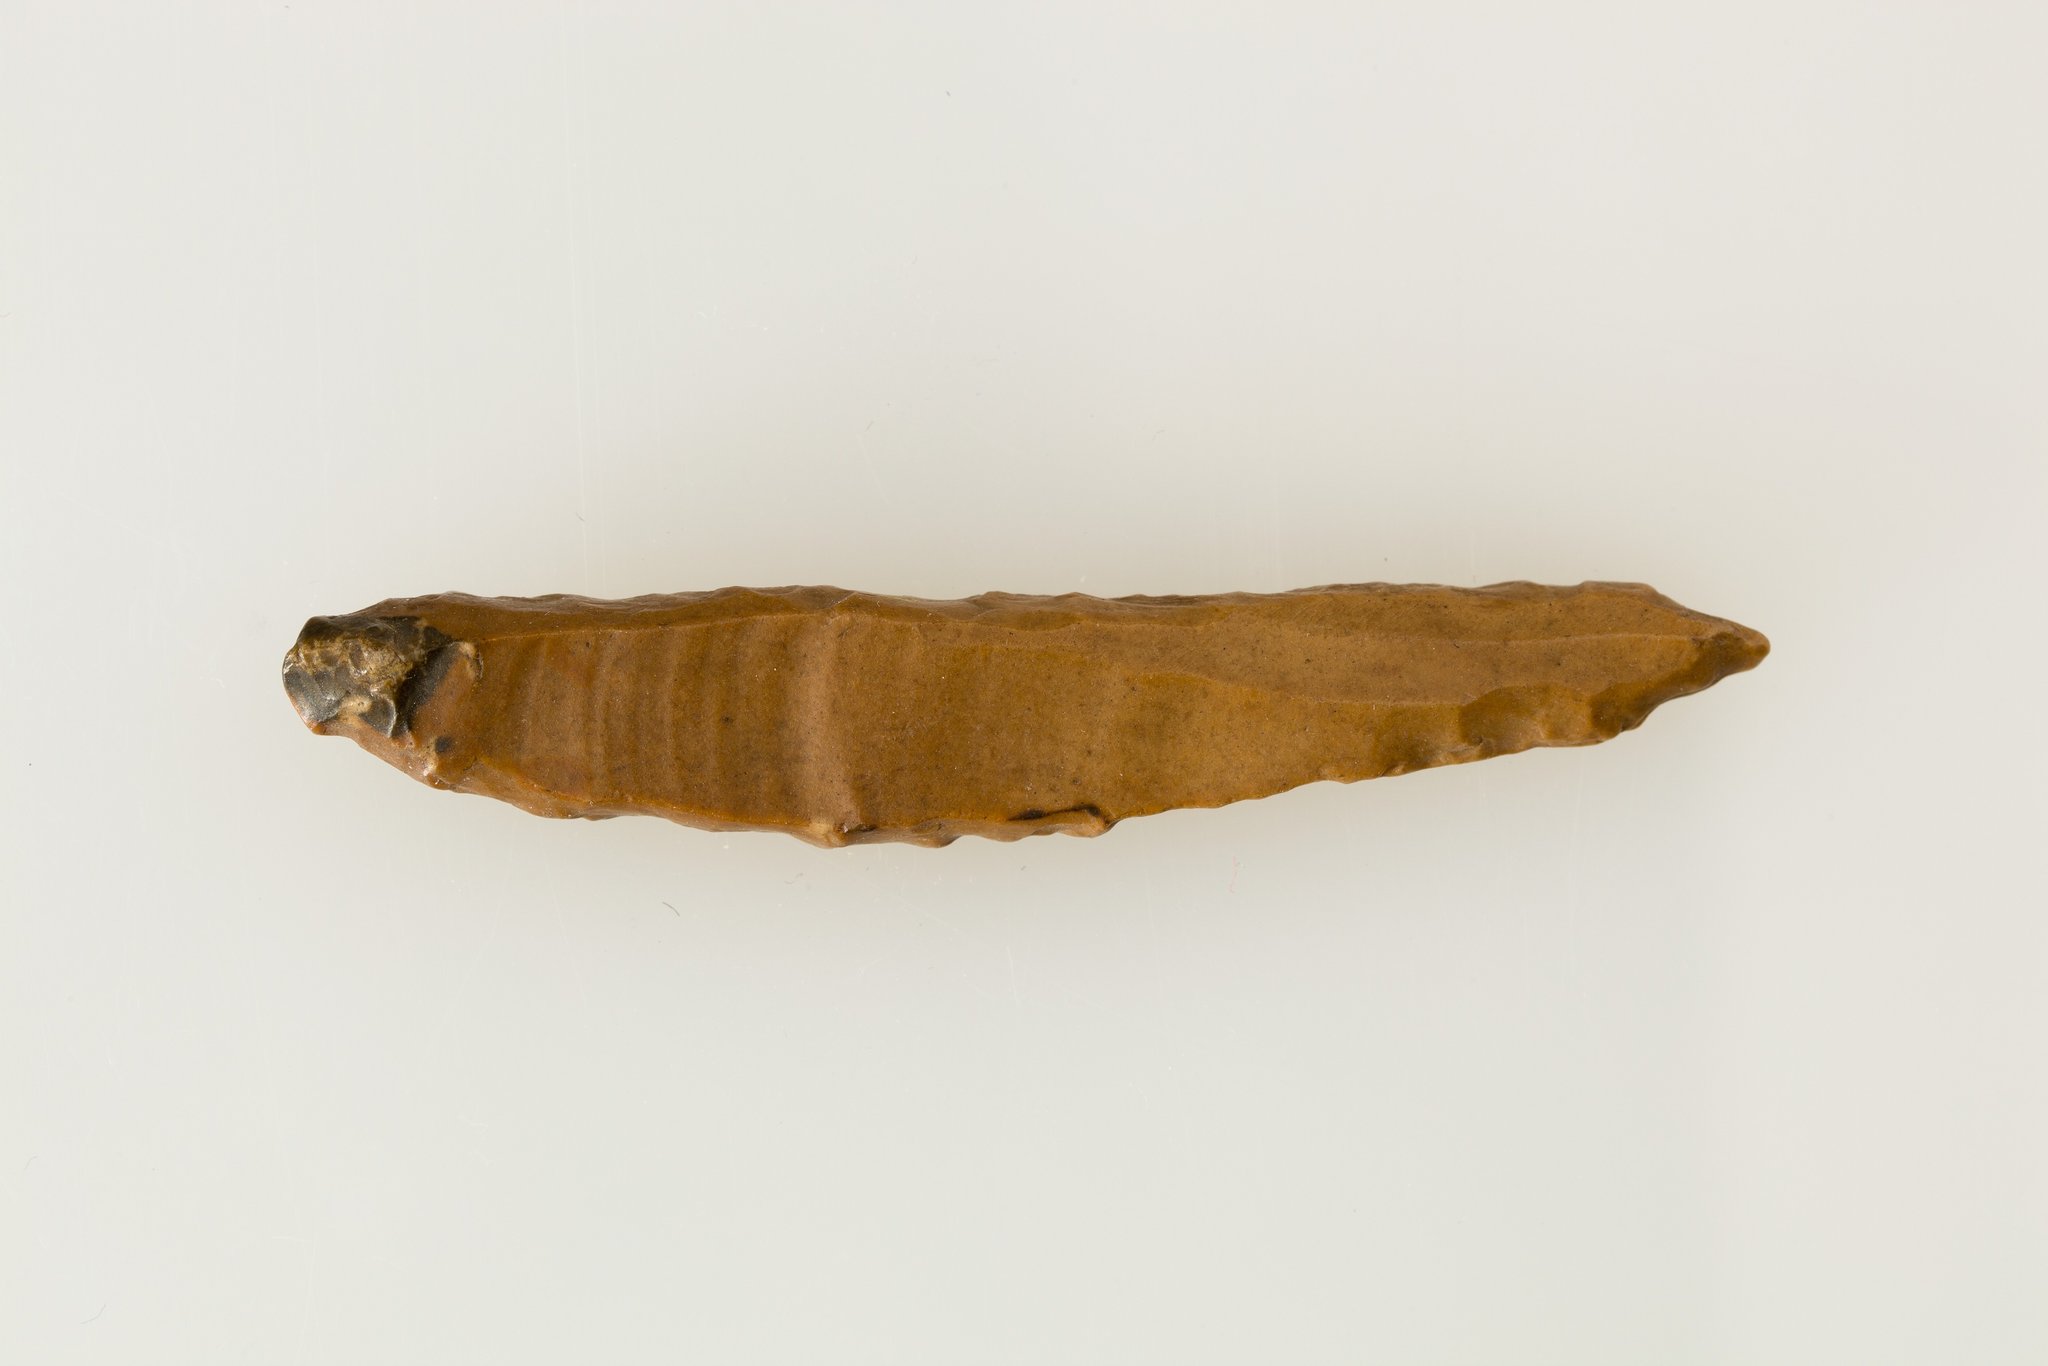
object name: tool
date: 3850-2960 BCE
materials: stone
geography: egypt